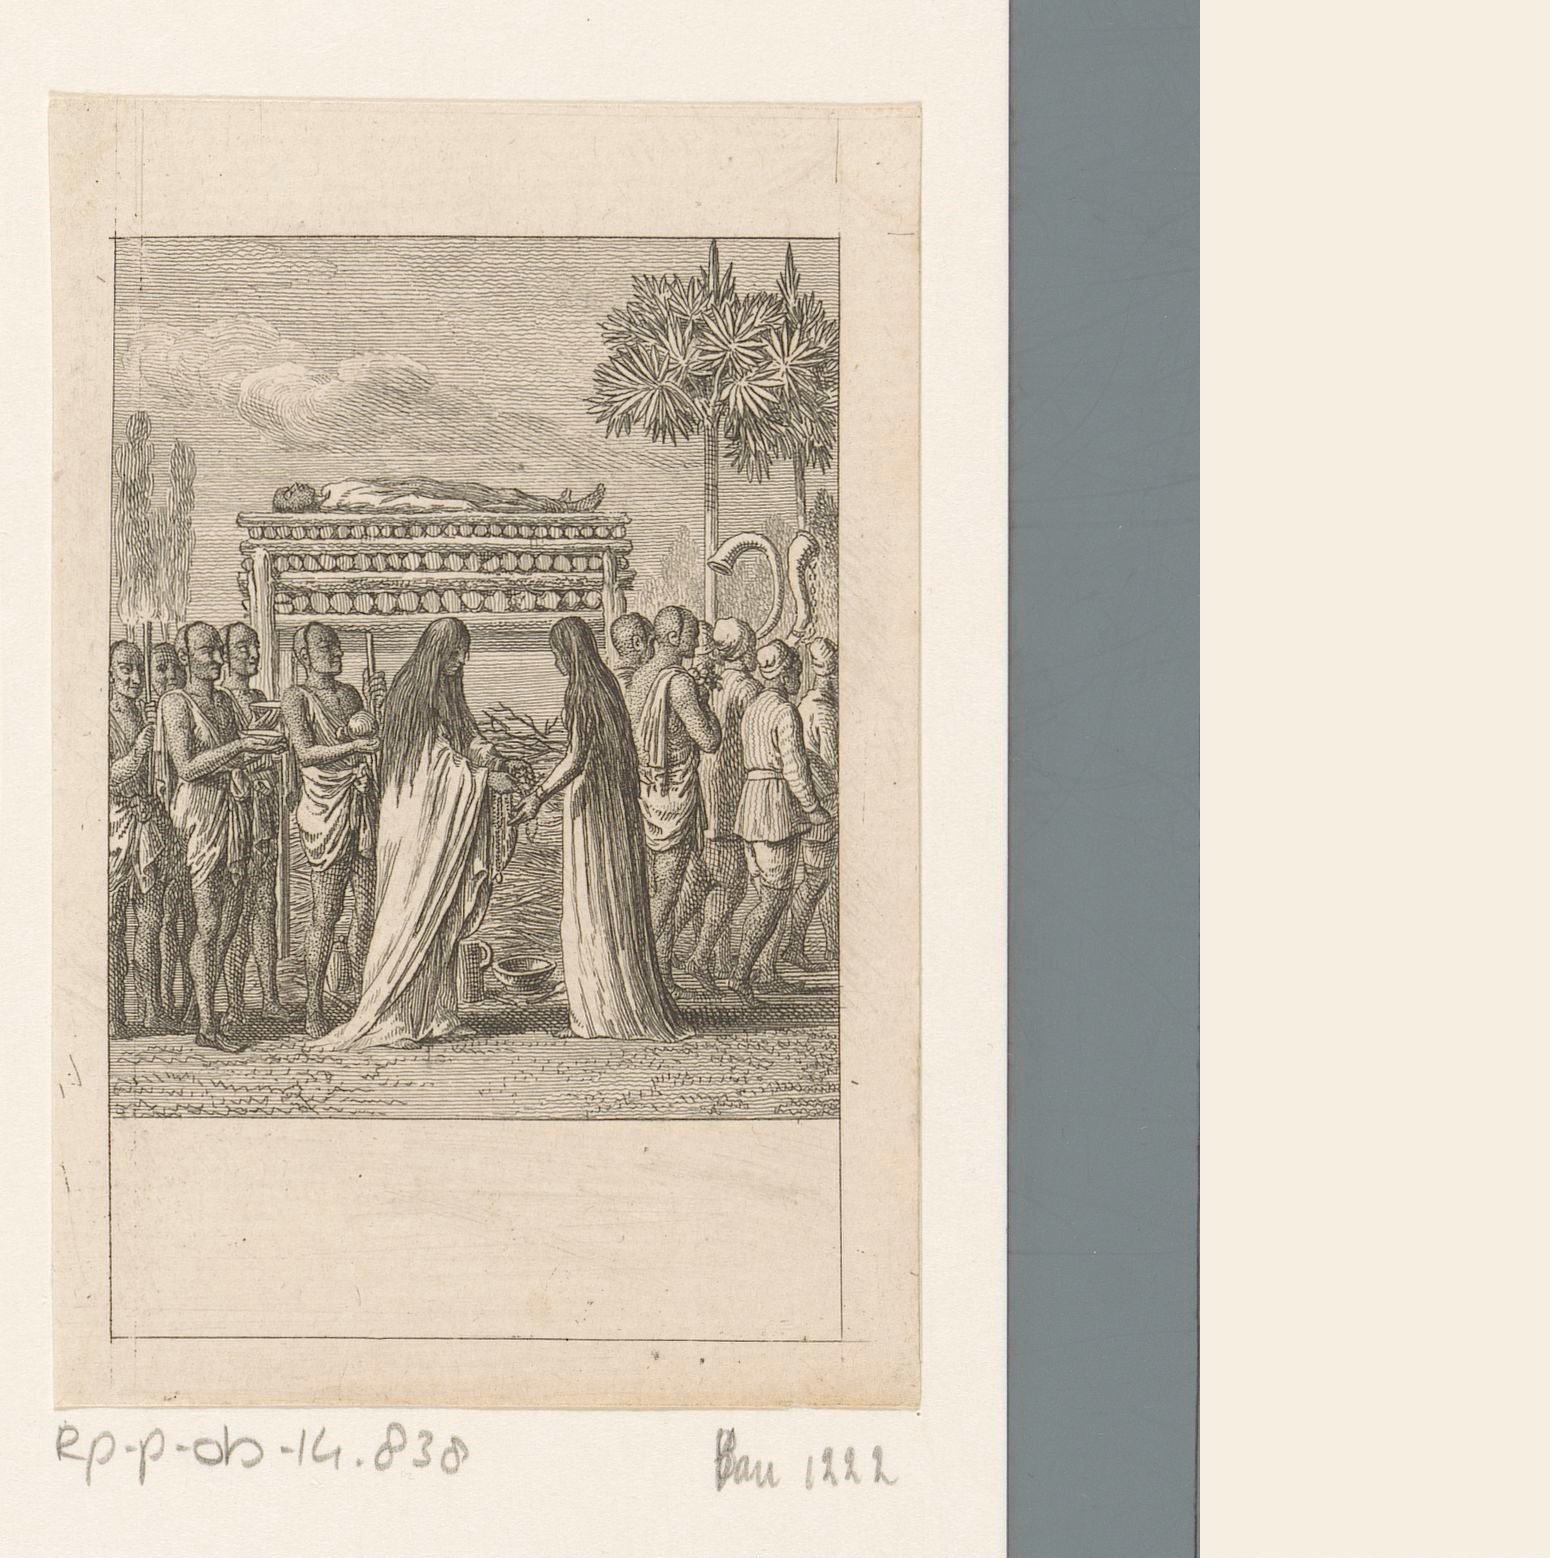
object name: print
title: Vrijwillige verbranding van de weduwe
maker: daniel nikolaus chodowiecki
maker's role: draughtsman, print maker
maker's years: 1726-1801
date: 1786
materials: paper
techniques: etching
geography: berlin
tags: human sacrifice ~ non-christian religions, widow, asiatic races and peoples: indians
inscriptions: collector's mark: Lugt 2228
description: Latere staat gebruikt voor: Sprengel, Matthias Christian. Historisch-genealogischer Calender, oder, Jahrbuch der merkwürdigsten neuen Welt-Begebenheiten für 1786. Leipzig: Zur Messe bey Haude und Spener von Berlin, s.a.